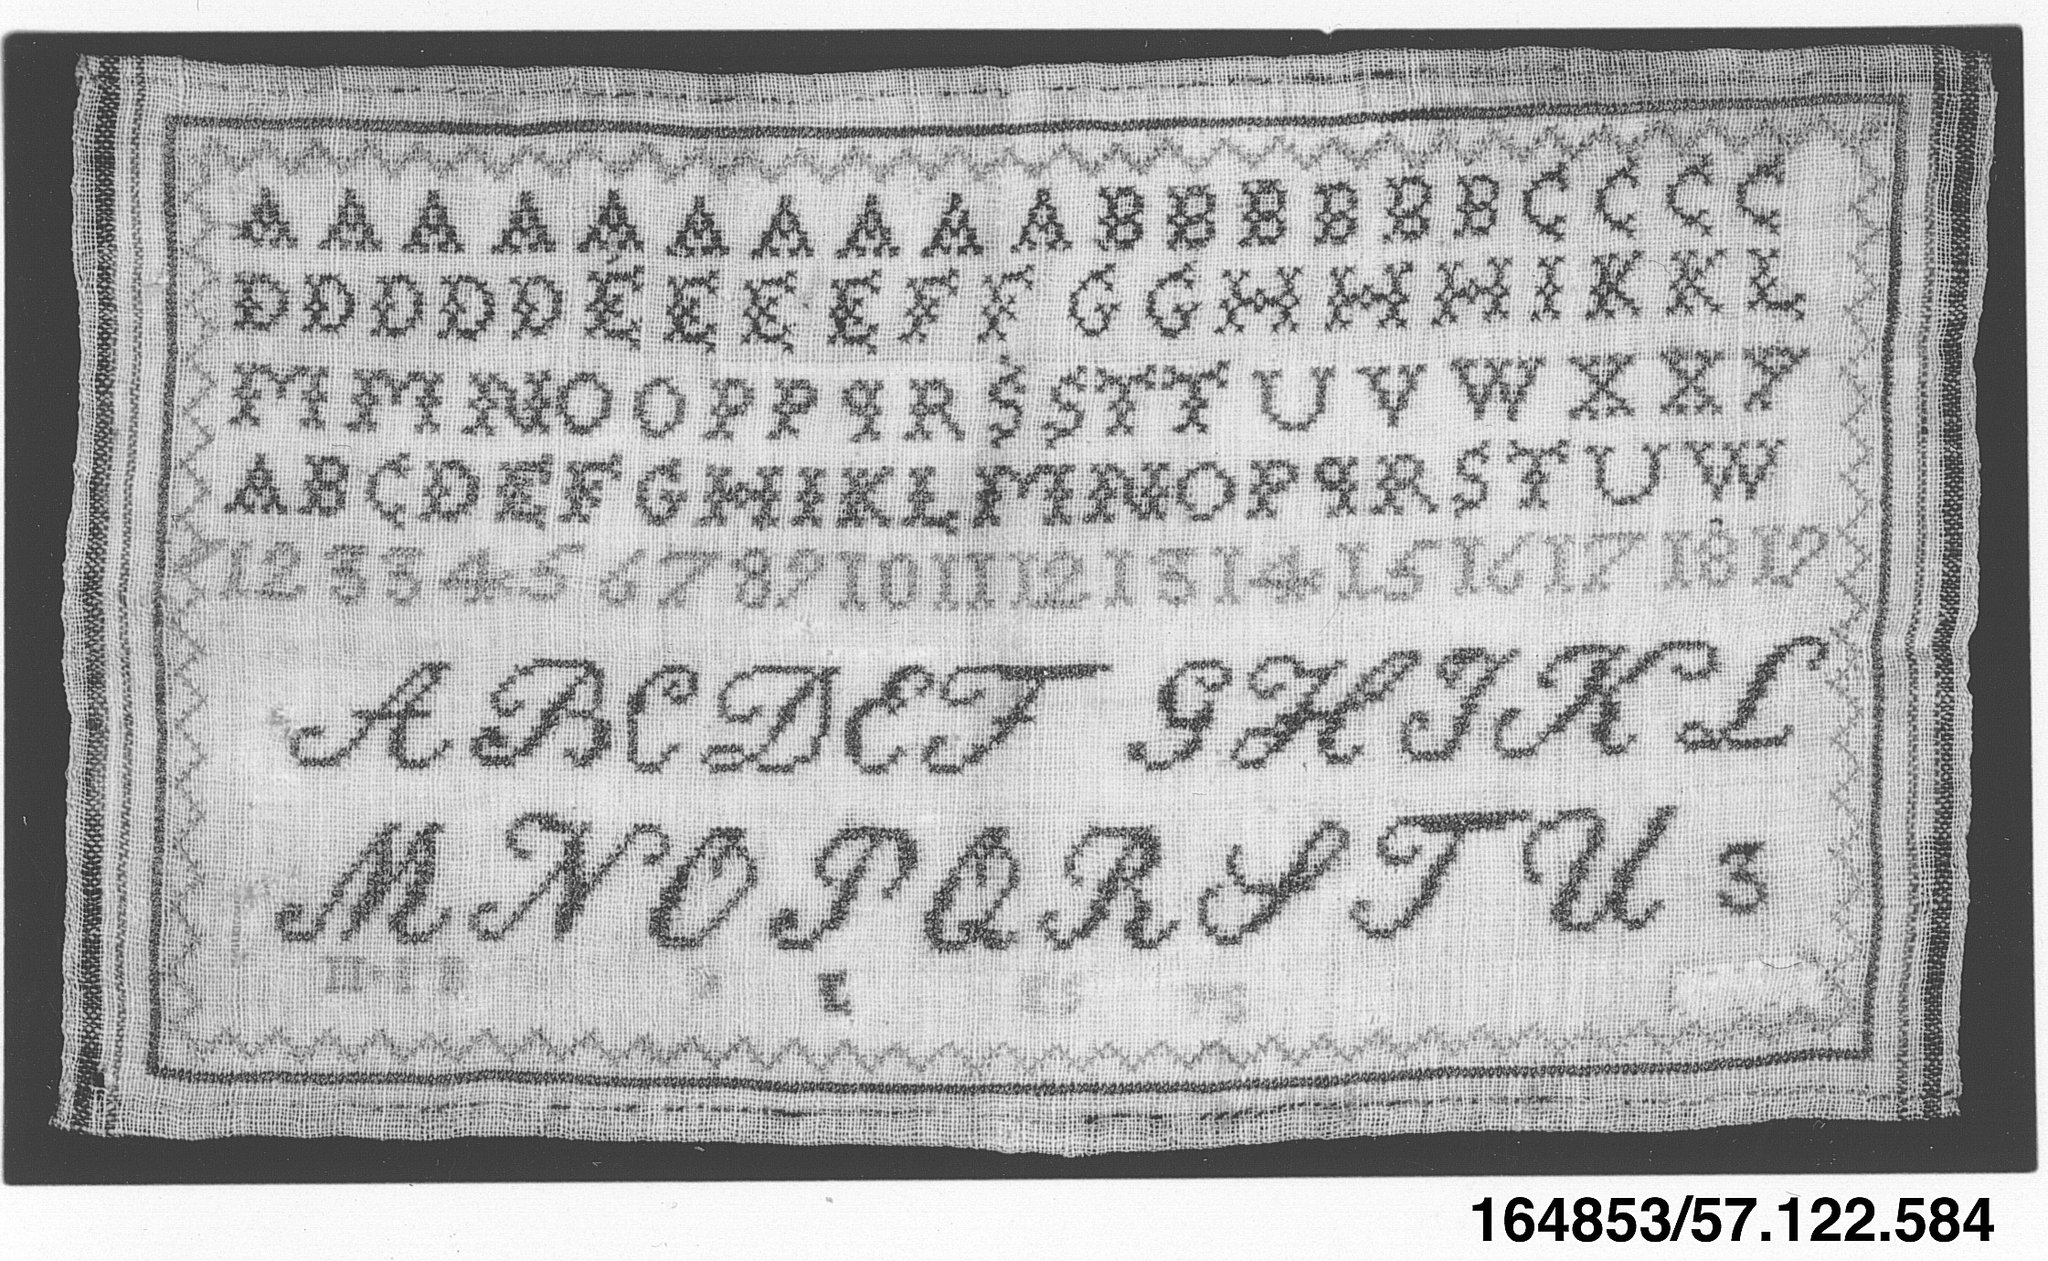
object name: sampler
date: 1801-1900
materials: canvas, wool